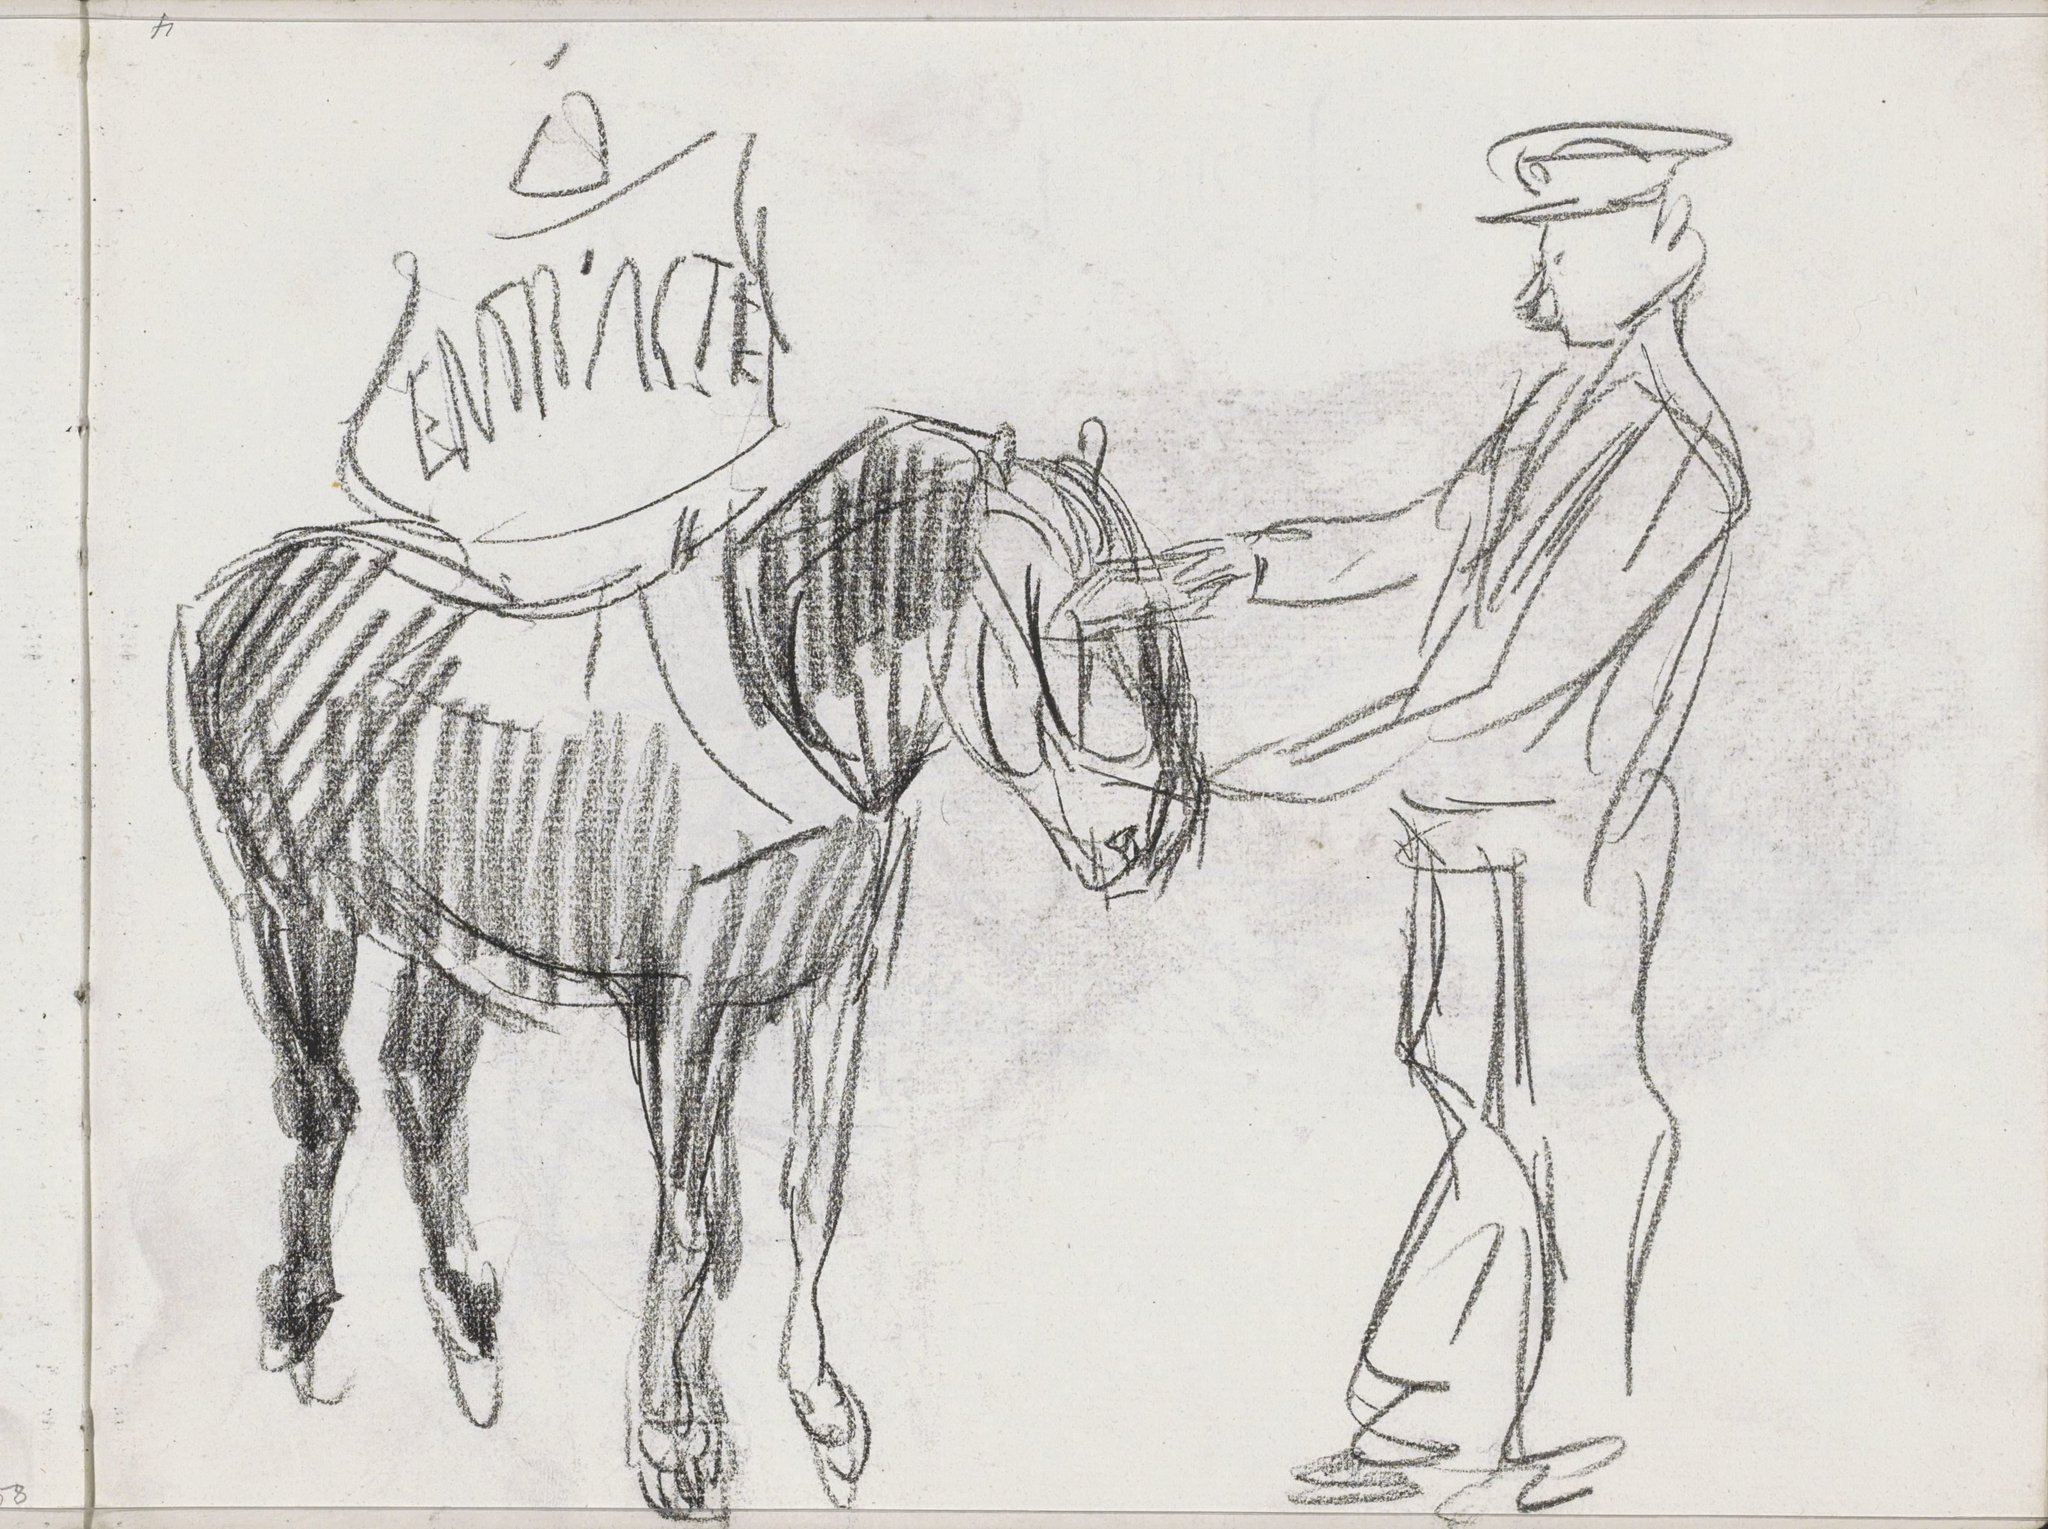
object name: sketchbook leaf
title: Man bij een ezel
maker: isaac israels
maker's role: draughtsman, painter, print maker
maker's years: 1865-1934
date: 1875-1934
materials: chalk, paper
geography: the hague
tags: ass, donkey, adult man (+ standing)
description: Op de rug van de ezel een bord met de tekst 'entr'acte' om tijdens voorstellingen aan te geven dat de er pauze was. Blad 28 recto uit schetsboek XXII met 30 bladen.